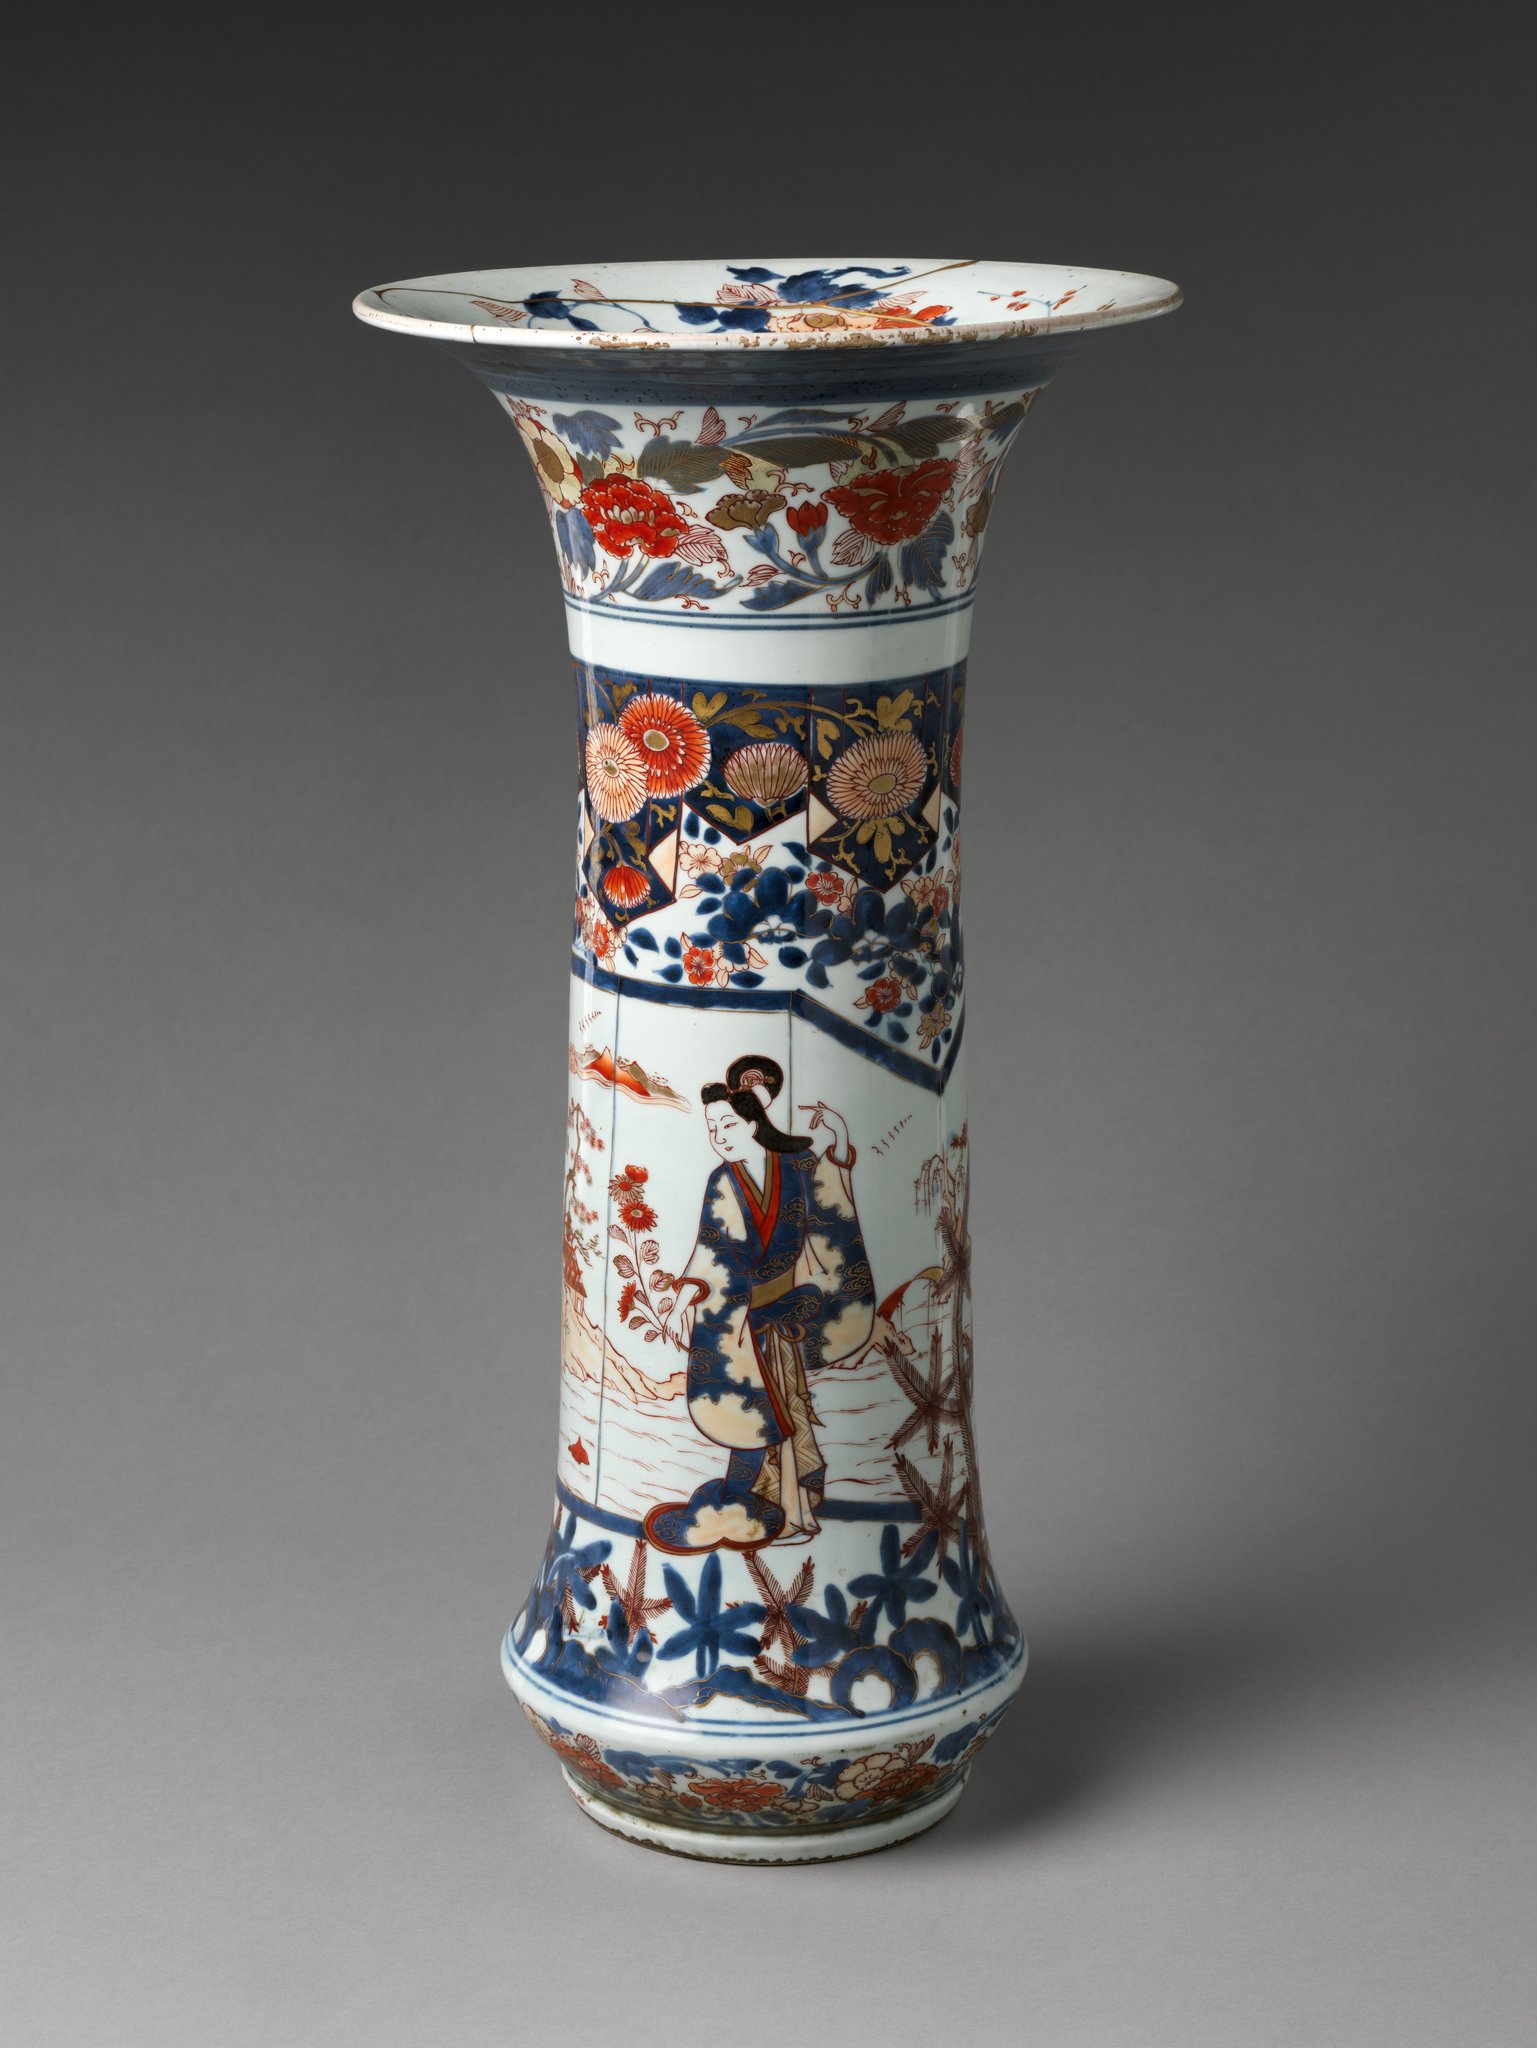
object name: vase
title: Vase in Trumpet Shape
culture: japanese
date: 1700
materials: enamel, gold, porcelain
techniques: polychrome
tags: flowers